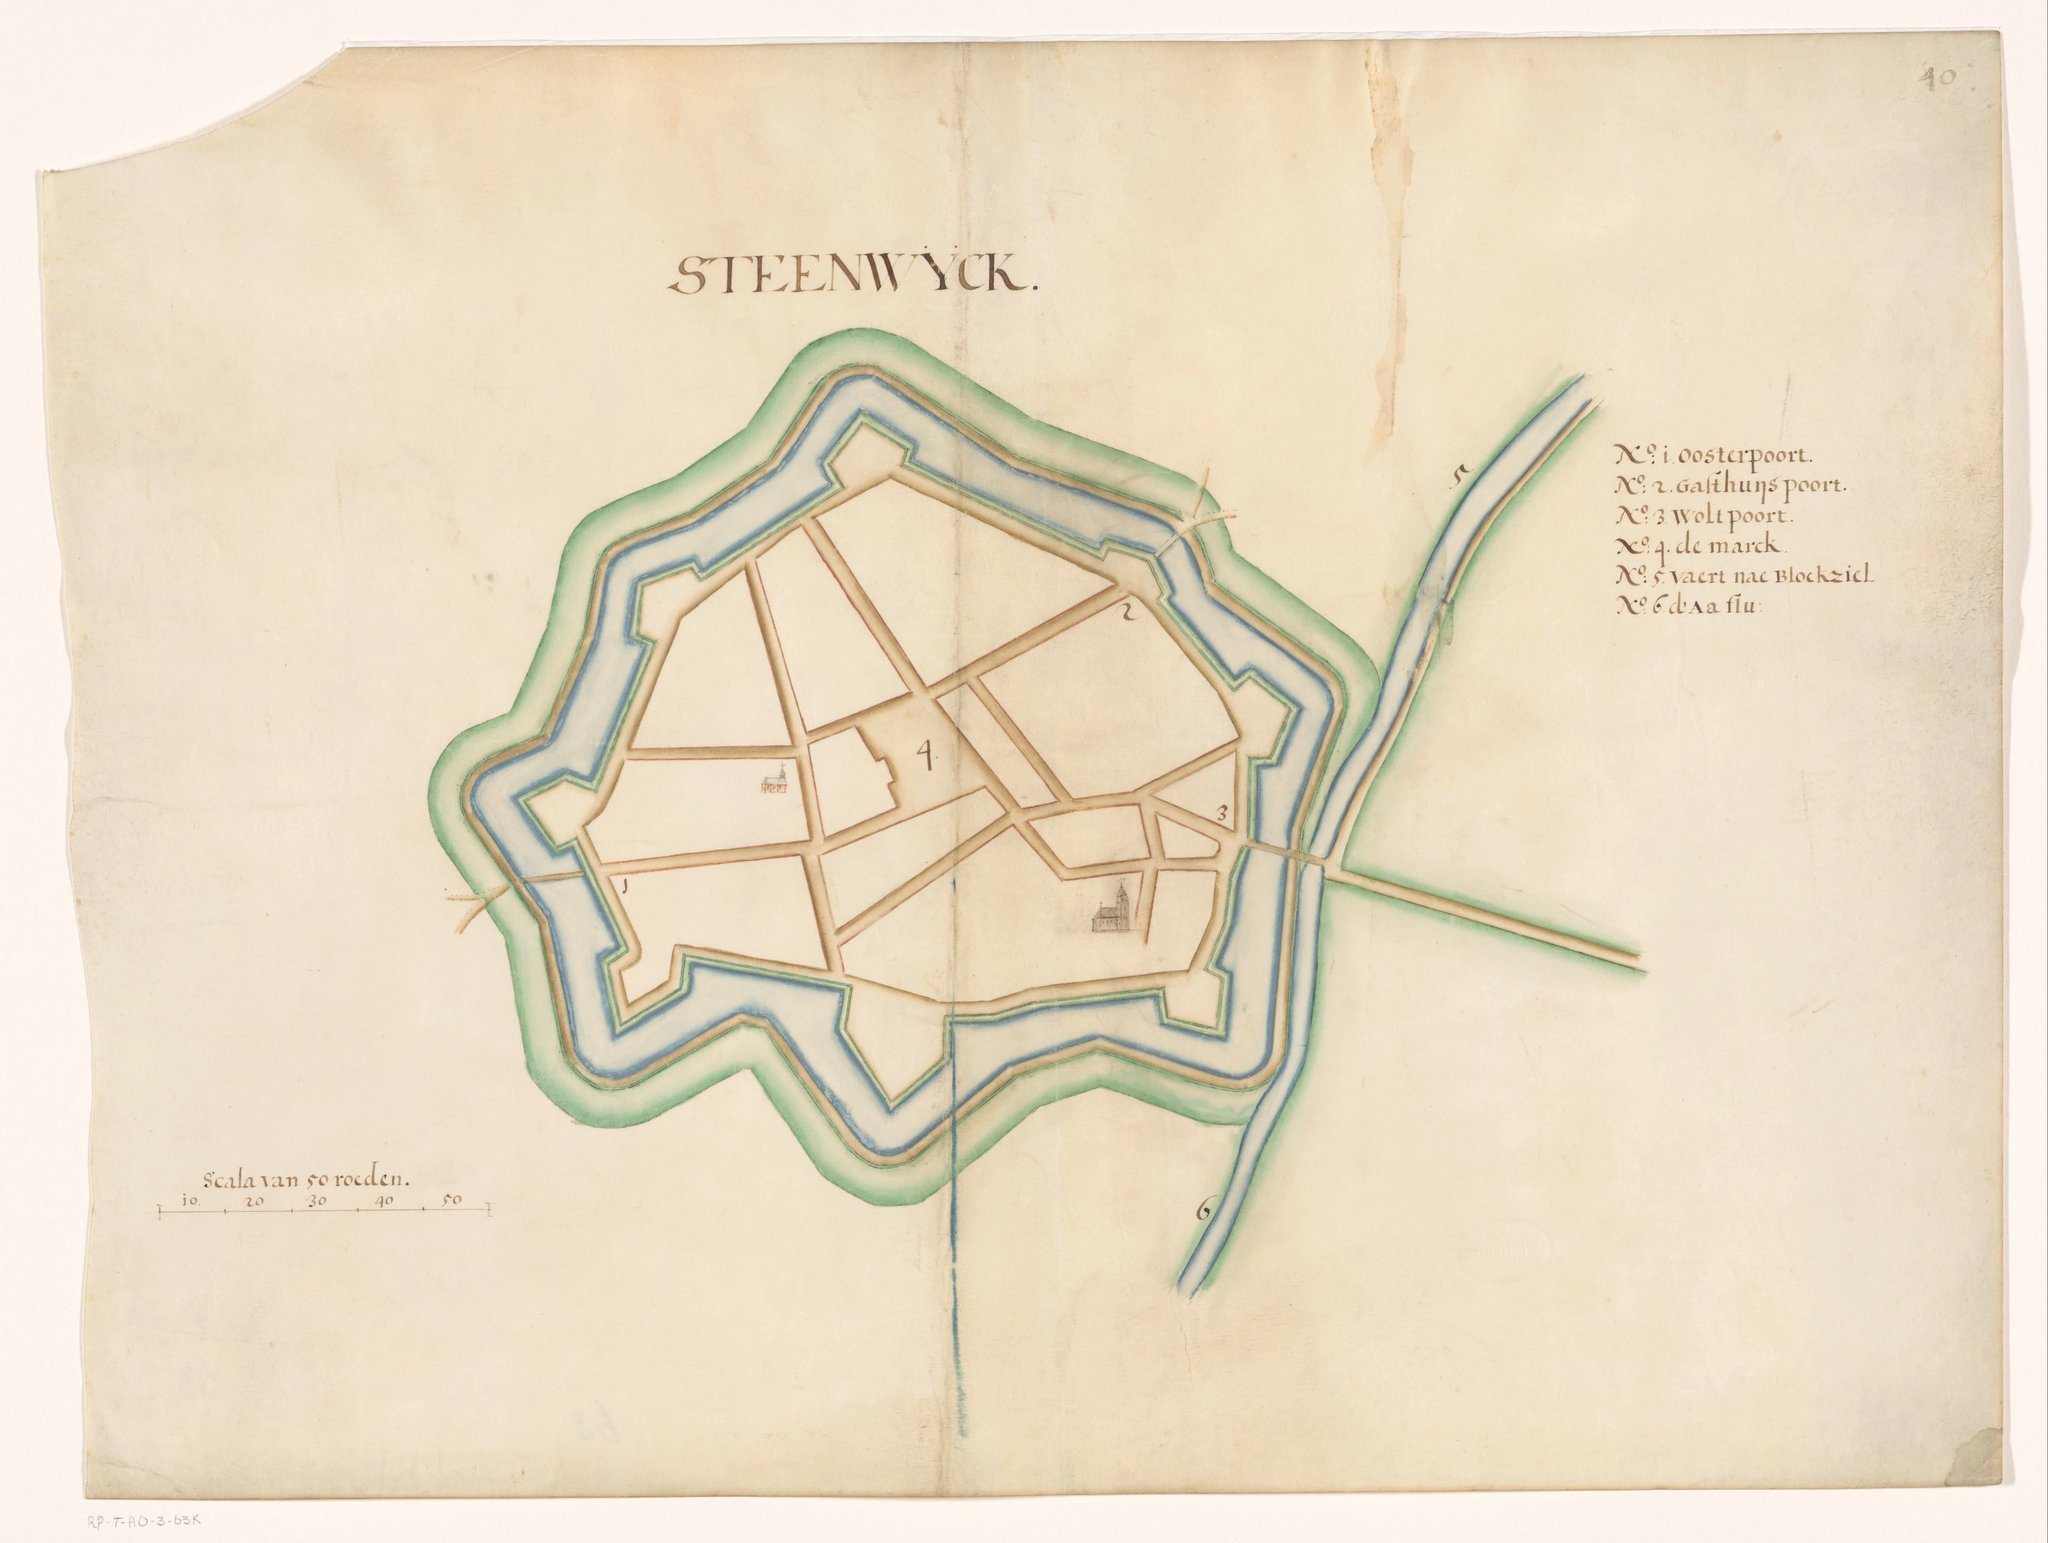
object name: area plan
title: Vestingplattegrond van Steenwijk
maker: Anonymous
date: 1650-1799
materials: ink, parchment, watercolor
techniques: brush, pen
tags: fortress, maps of cities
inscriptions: check stamp: ‘Archief Ministerie van Oorlog Afdeeling Genie’, collector's mark: Lugt 2228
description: Linksonder een schaalstok: Scala van 50 roeden. Rechtsboven een legenda.